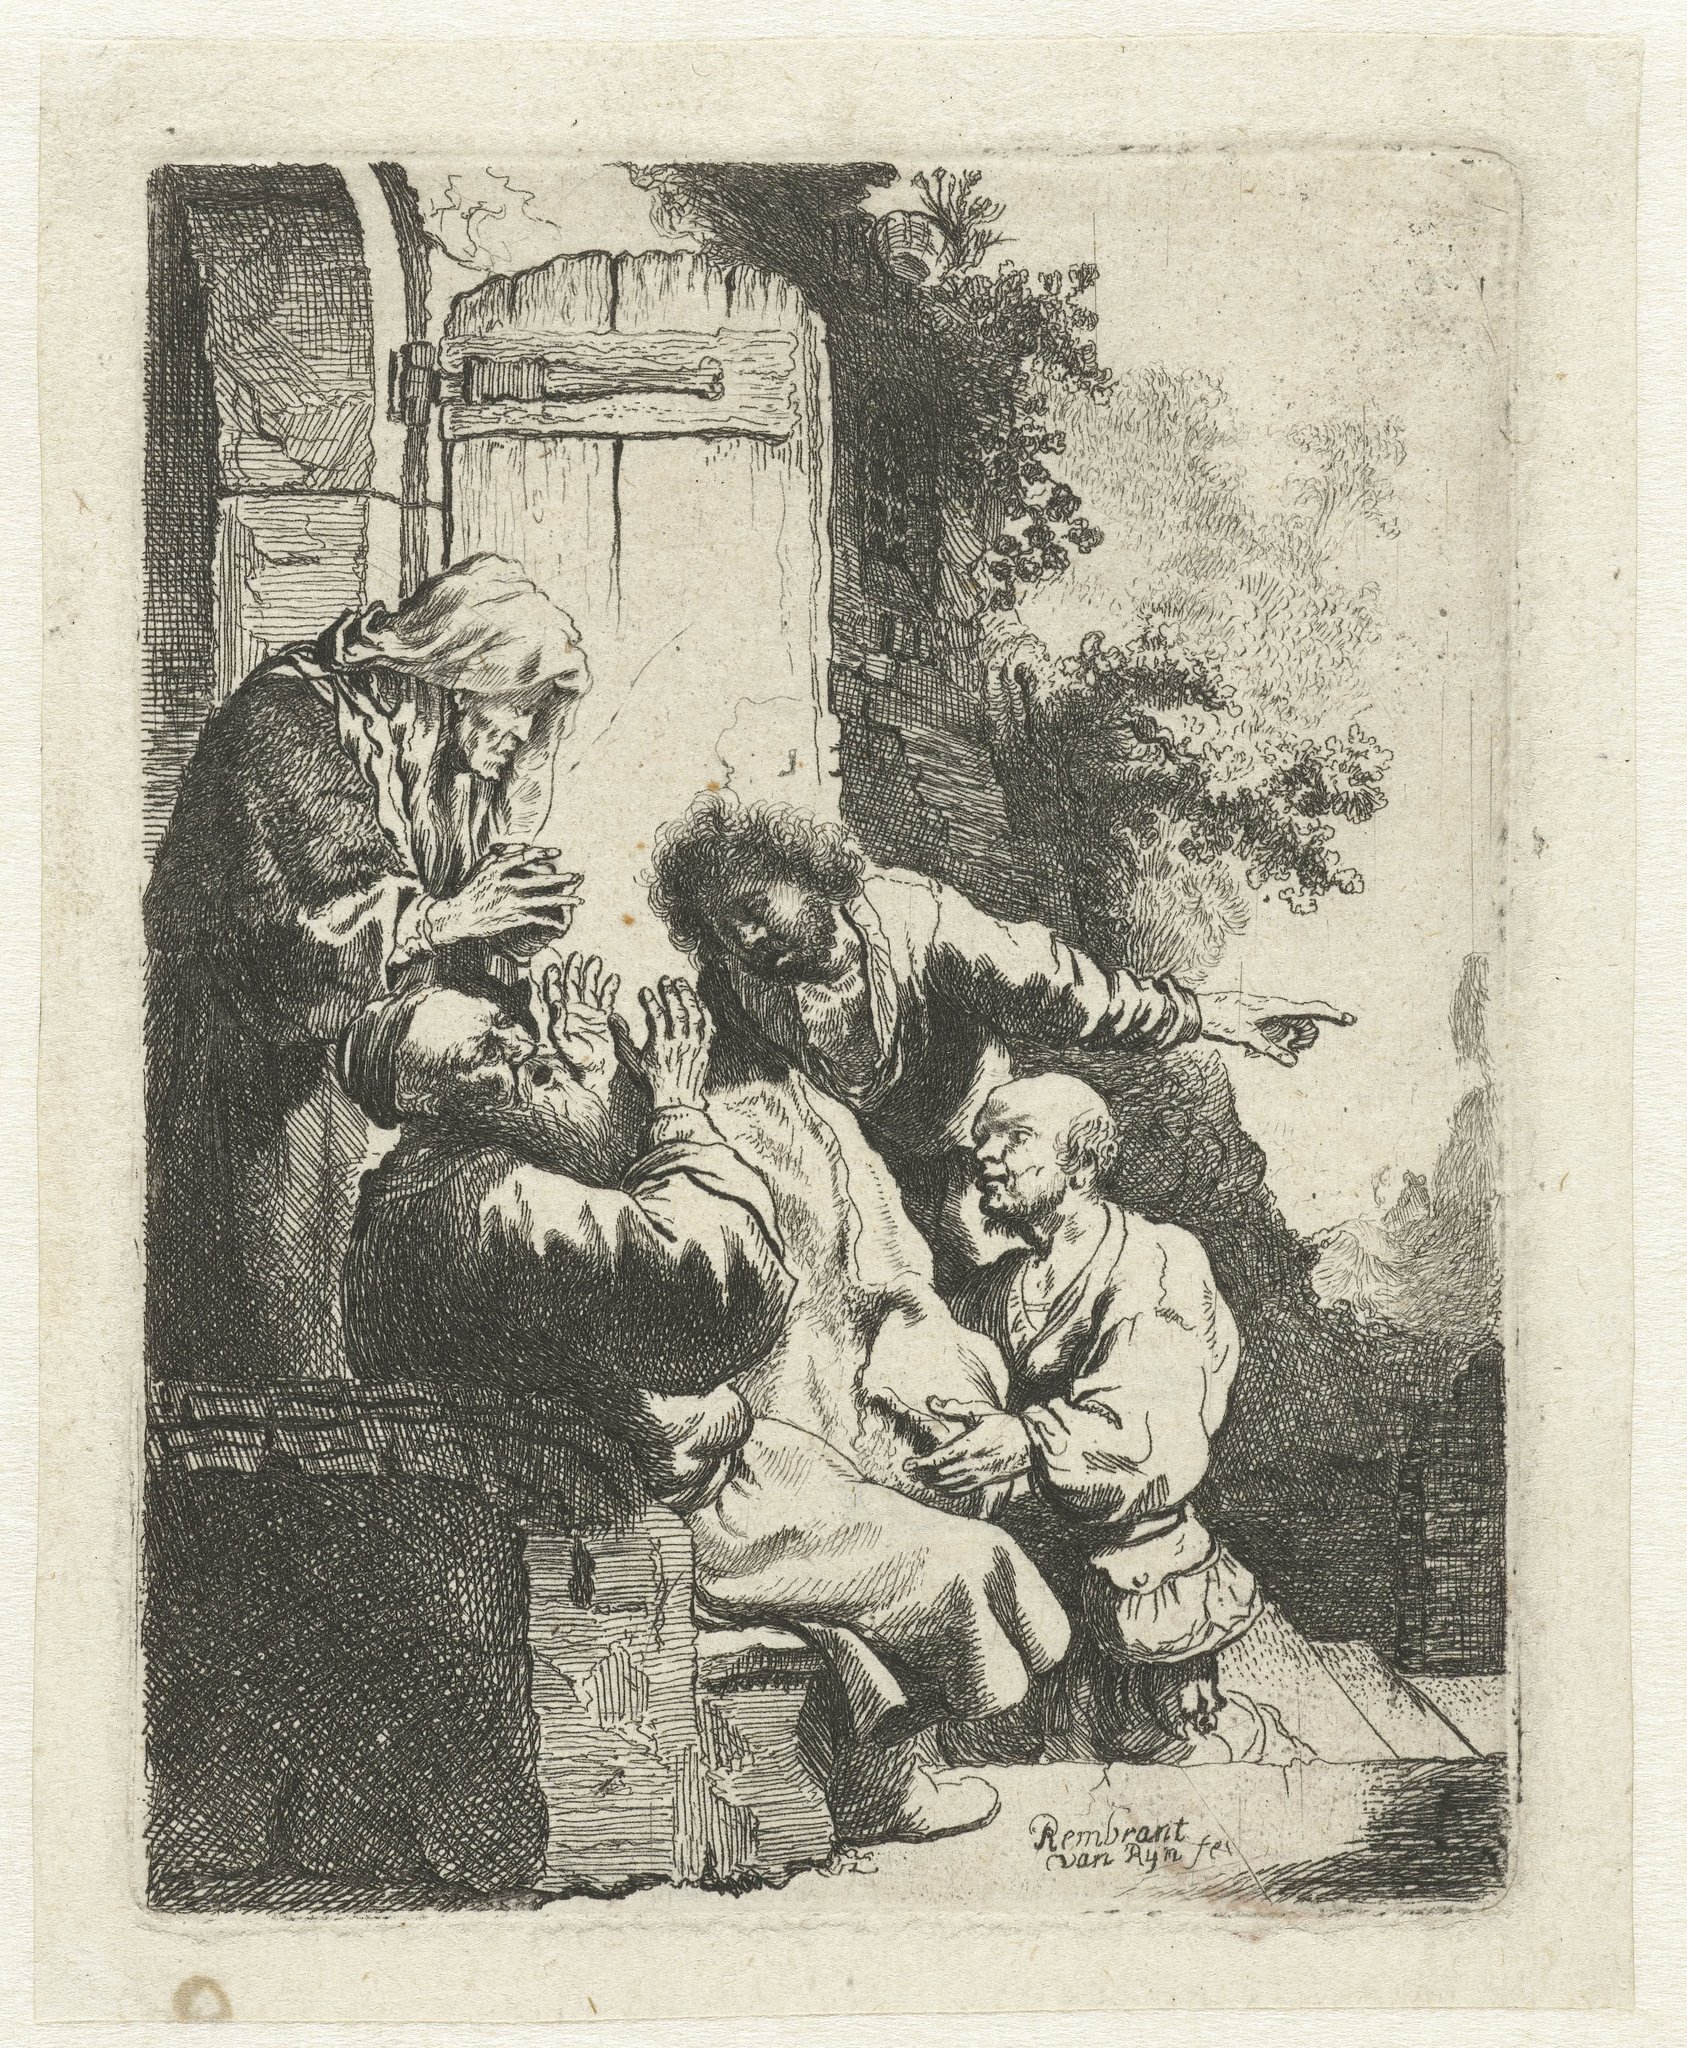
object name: print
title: Joseph's coat brought to Jacob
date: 1633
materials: paper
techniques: etching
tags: joseph's blood-stained coat is brought and shown to jacob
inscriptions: collector's mark: Lugt 240